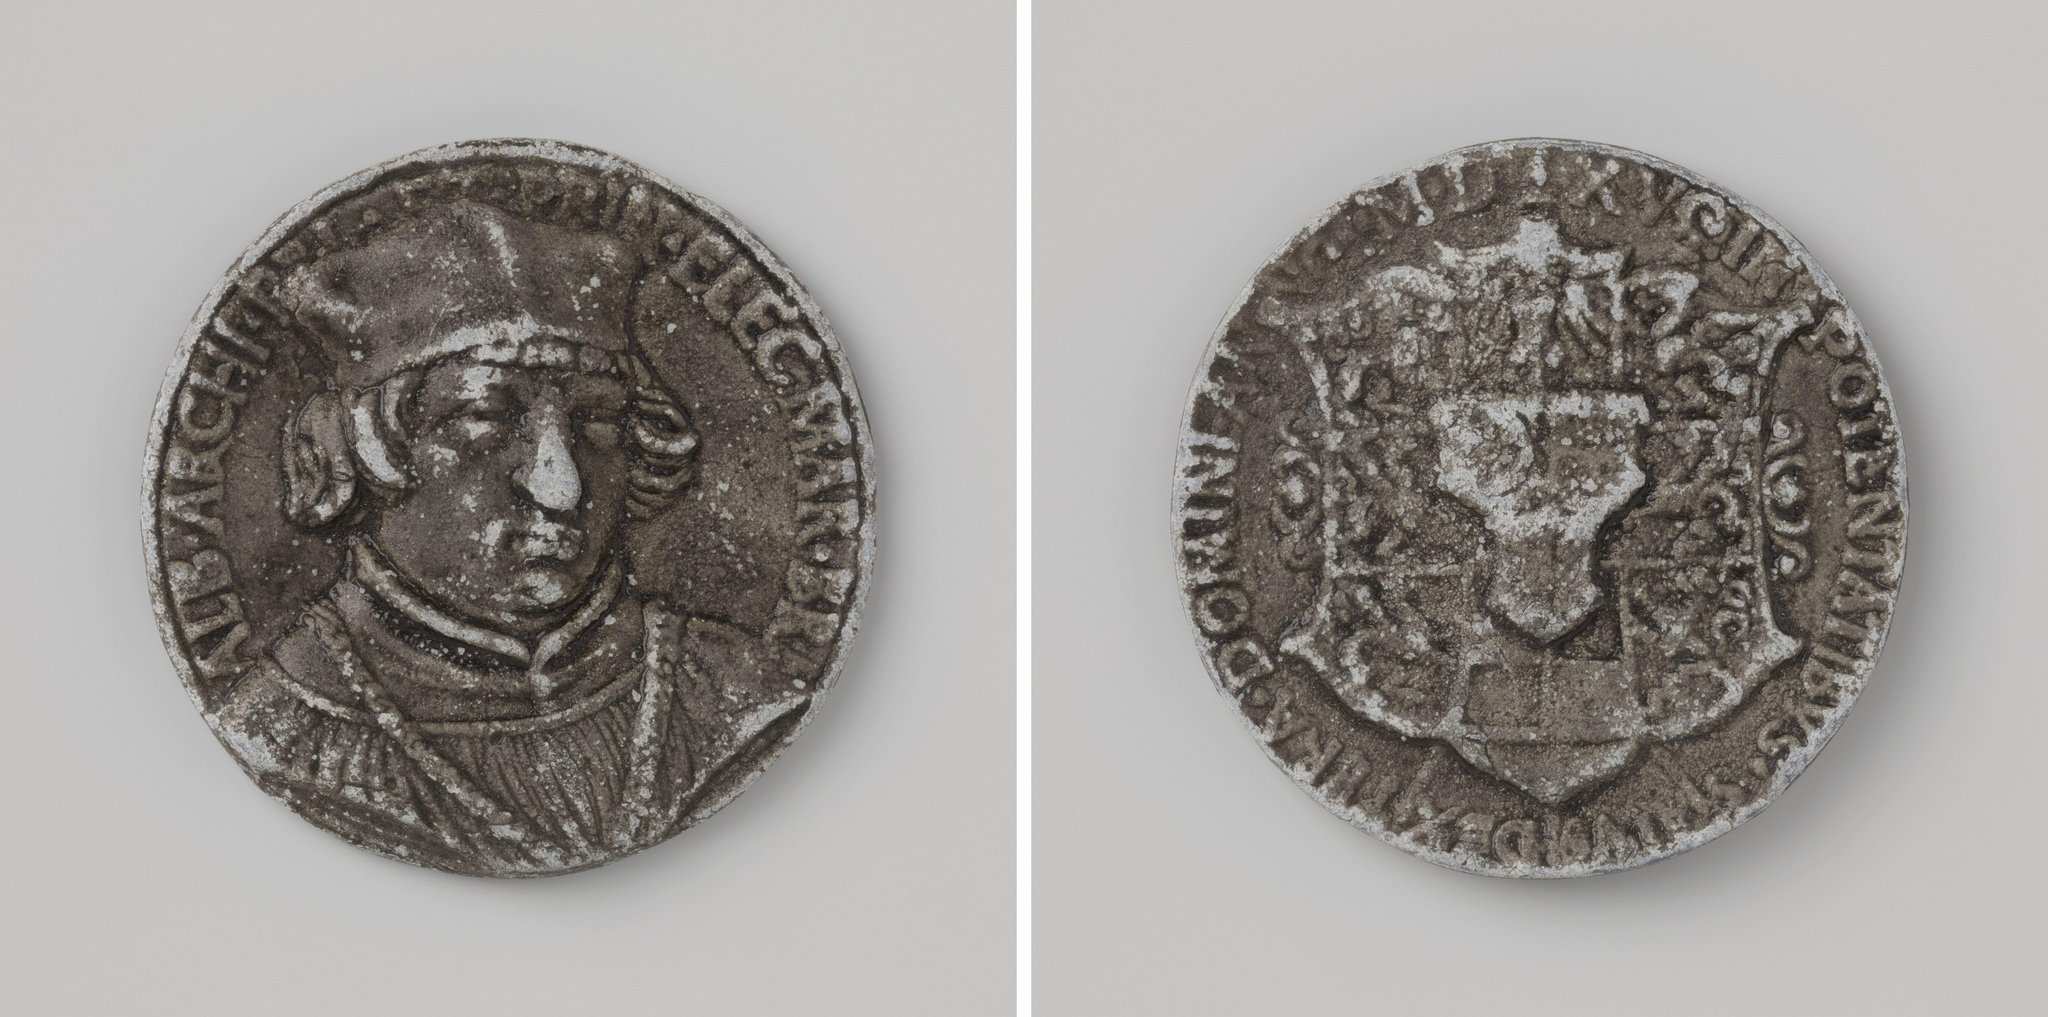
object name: history medal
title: Aartsbisschop Albrecht van Brandenburg 1515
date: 1515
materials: lead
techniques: casting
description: Gegoten loden penning, op de voorzijde het portret van Albrecht, schuin naar rechts kijkend, met omschrift, op de keerzijde een meerdelig wapenschild met omschrift